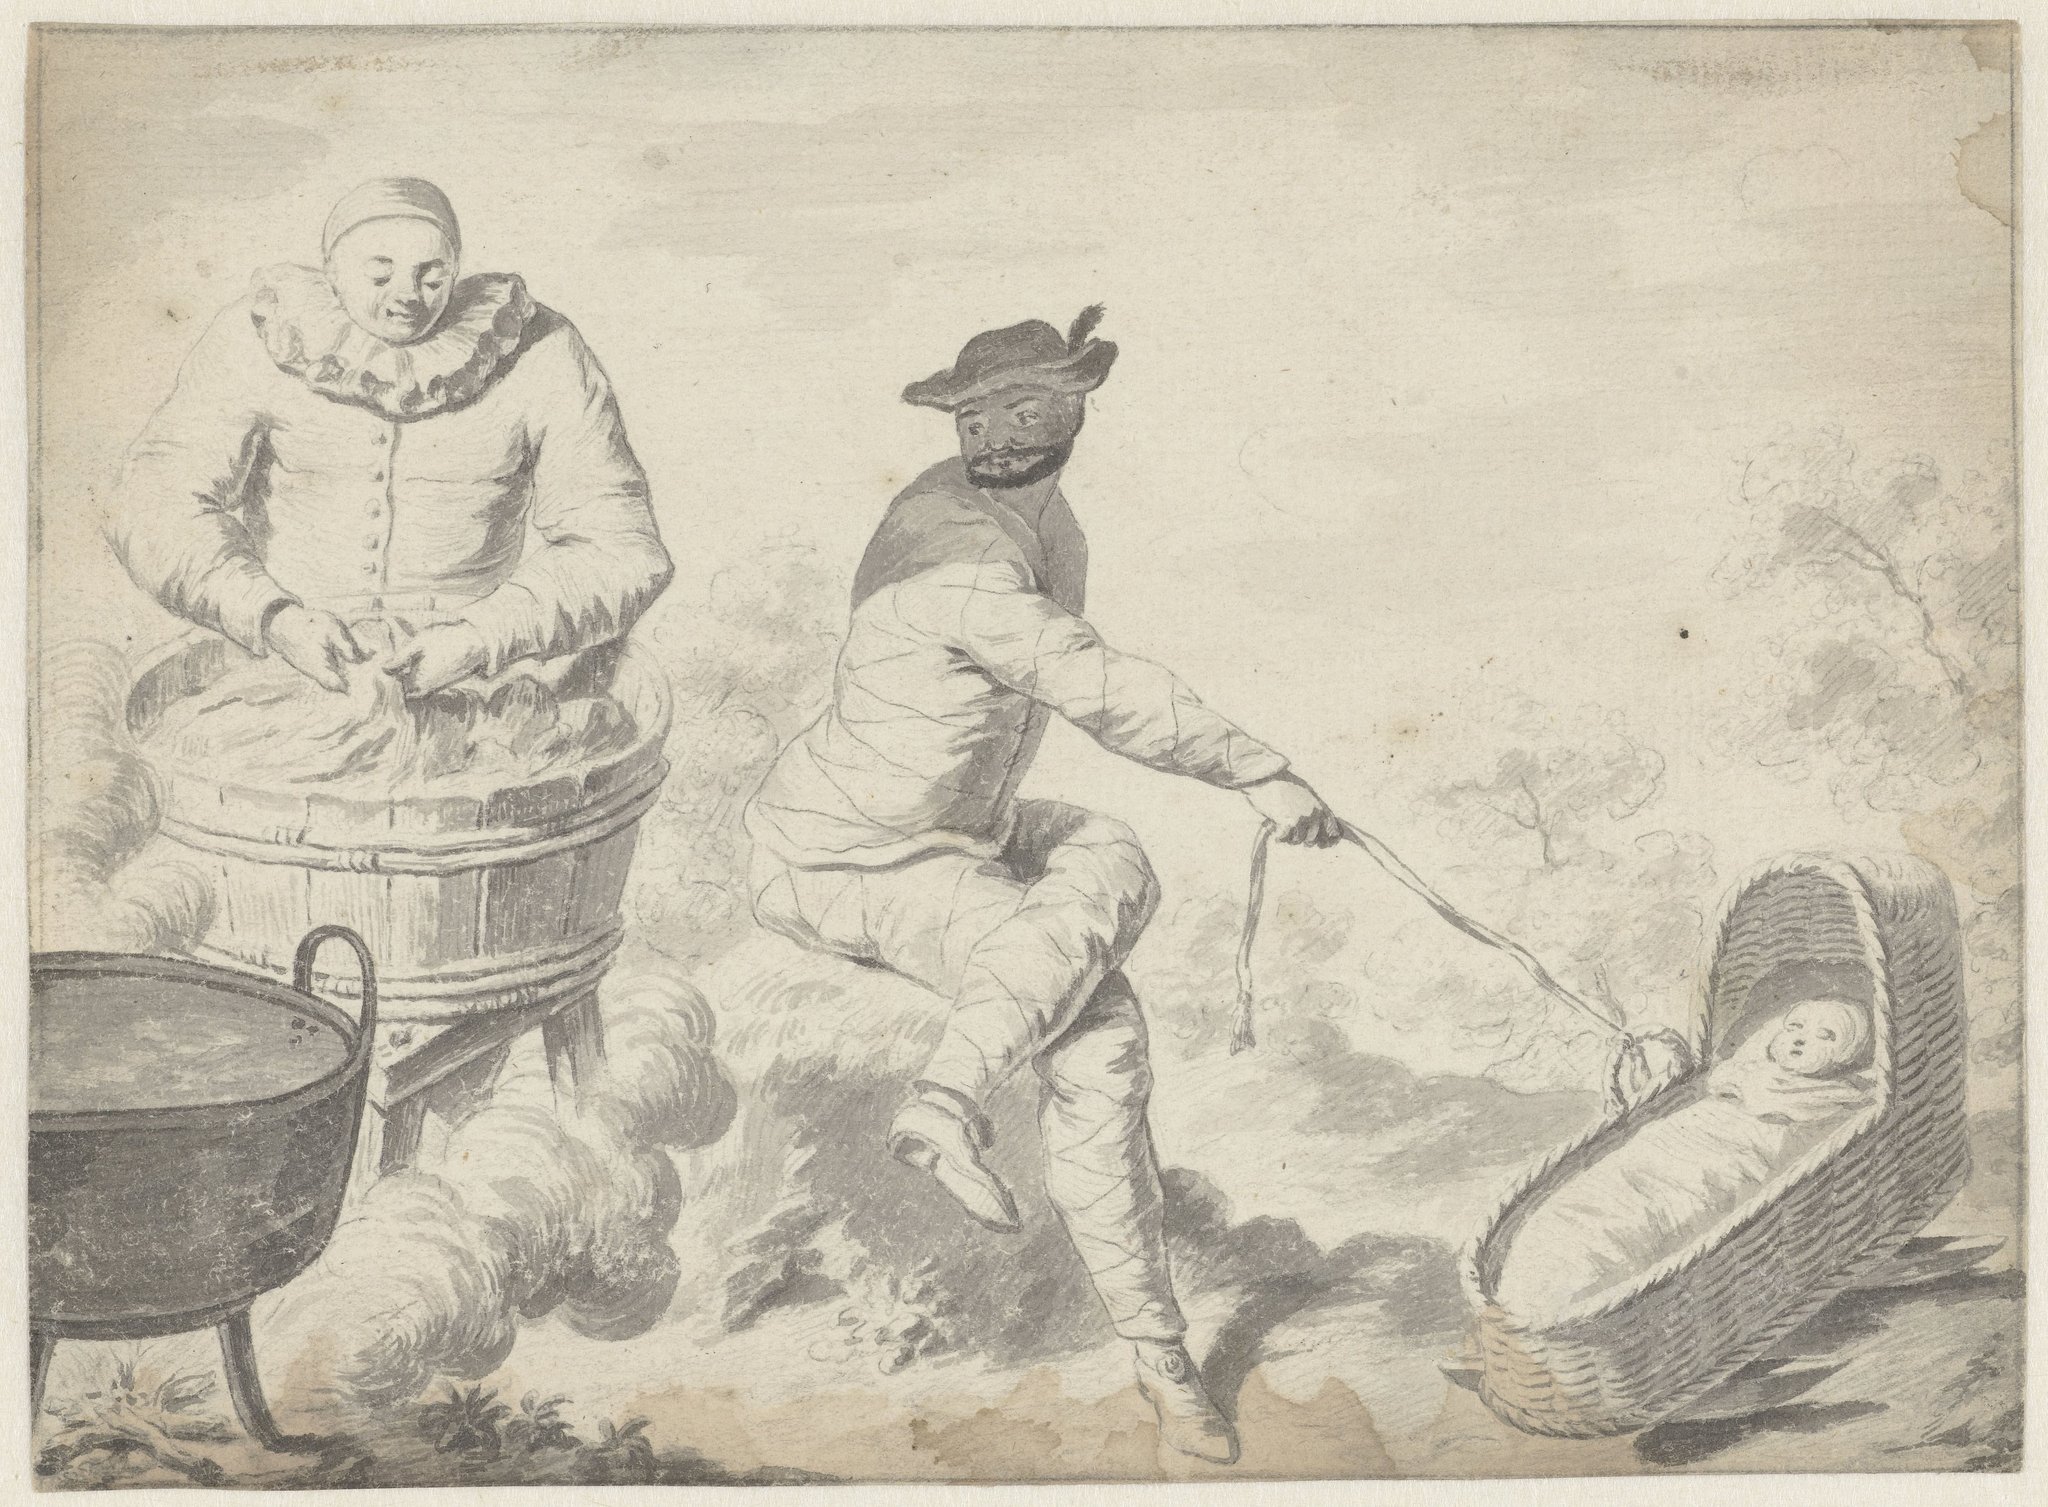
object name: drawing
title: Scène uit de Commedia dell'Arte met Pierrot die de was doet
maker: gerardus josephus xavery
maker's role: draughtsman, print maker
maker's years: 1700-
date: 1710-1800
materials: chalk, ink, paper, pencil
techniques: brush, pen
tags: (scenes from) specific works of literature (with author, title), 'commedia dell'arte'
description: Scène uit de Commedia dell'Arte: een man wiegt een kind in een wieg, Pierrot doet de was. Ontwerp voor een prent bij de 'Wonderbaarlijke ziekte van Harlequin'.